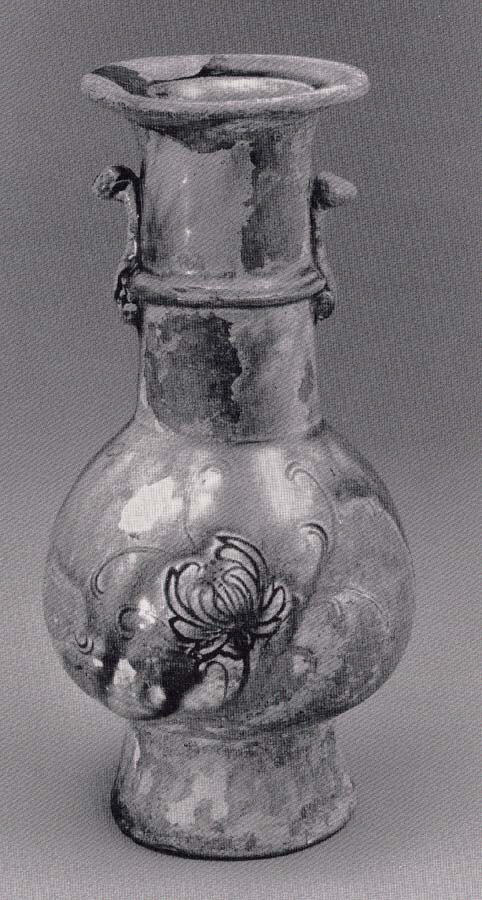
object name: flower vase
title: Flower Vase with Stamped Design of Lotus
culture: japanese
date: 1301-1400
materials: earthenware, glaze, iron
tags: flowers